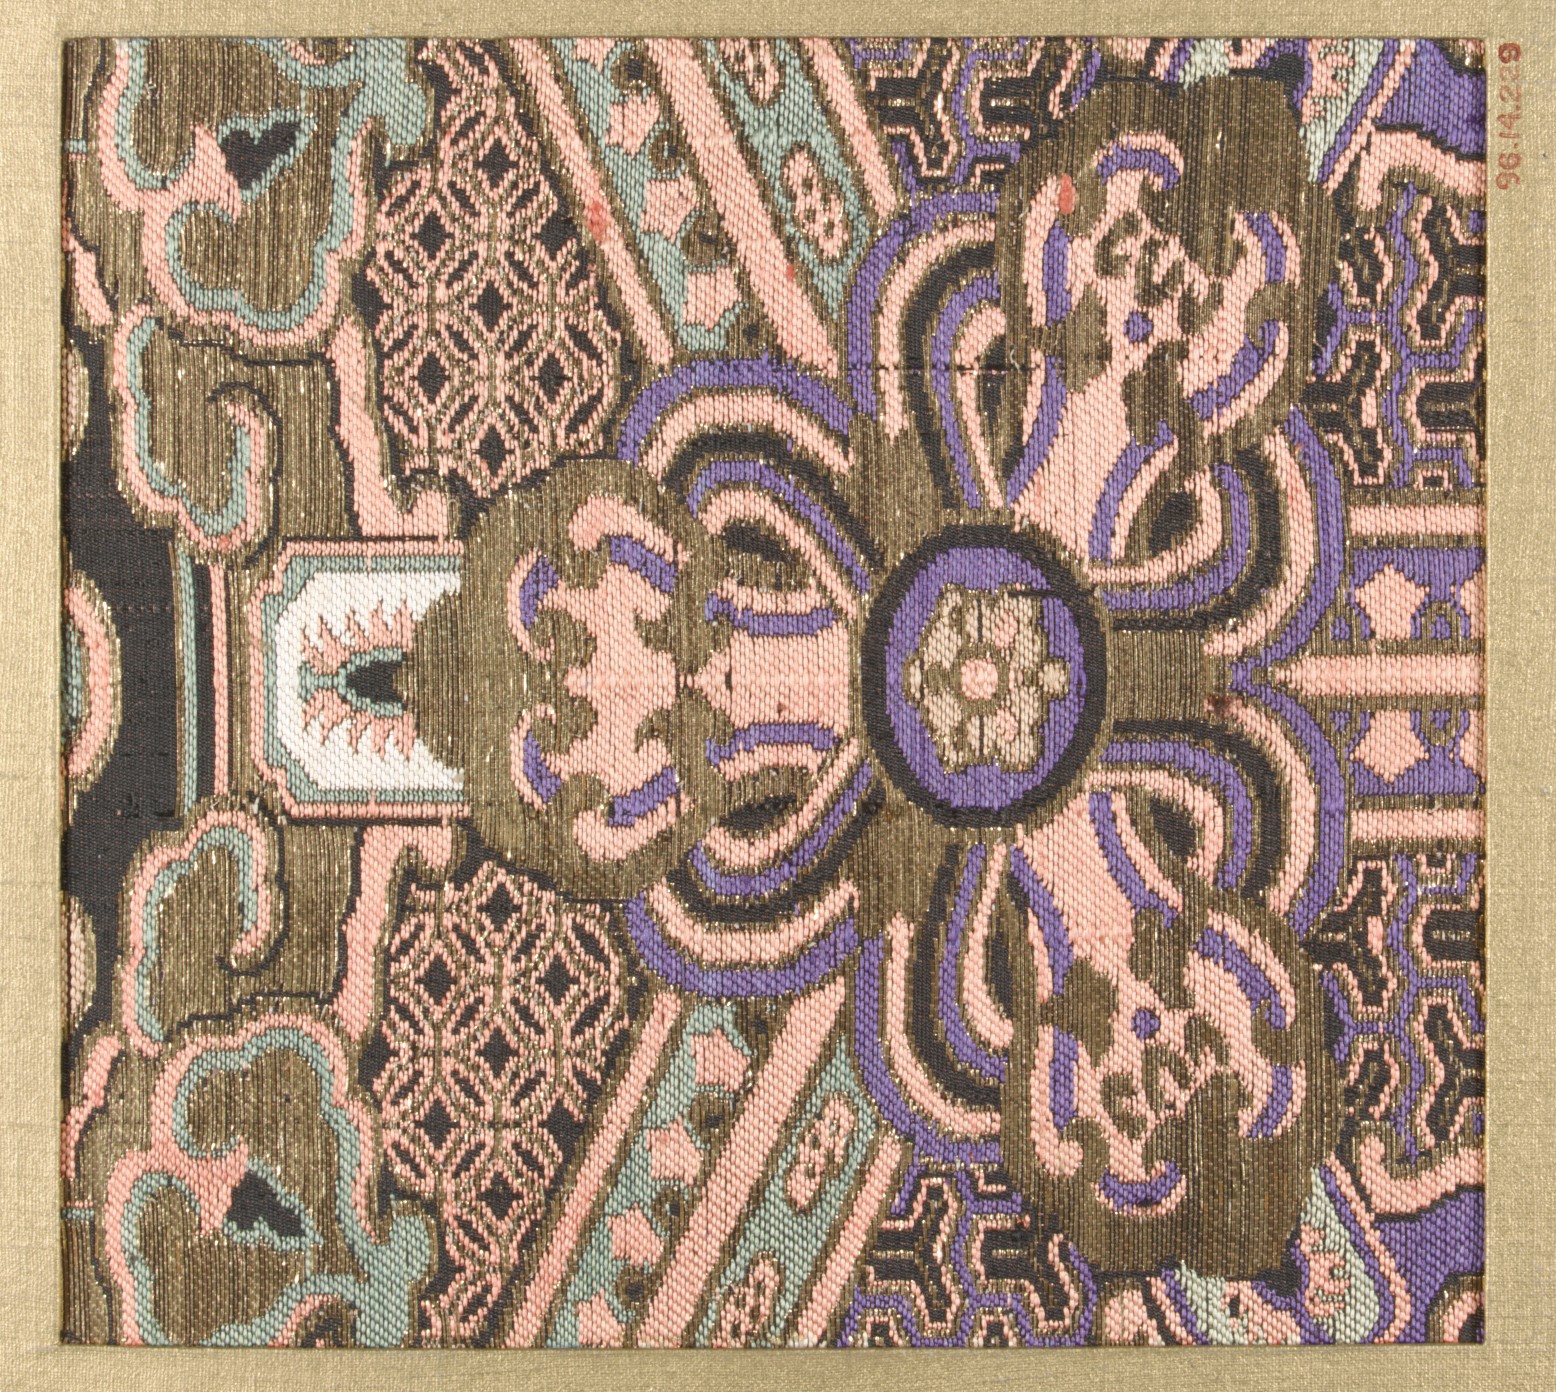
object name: piece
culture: japanese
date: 1701-1900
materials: silk